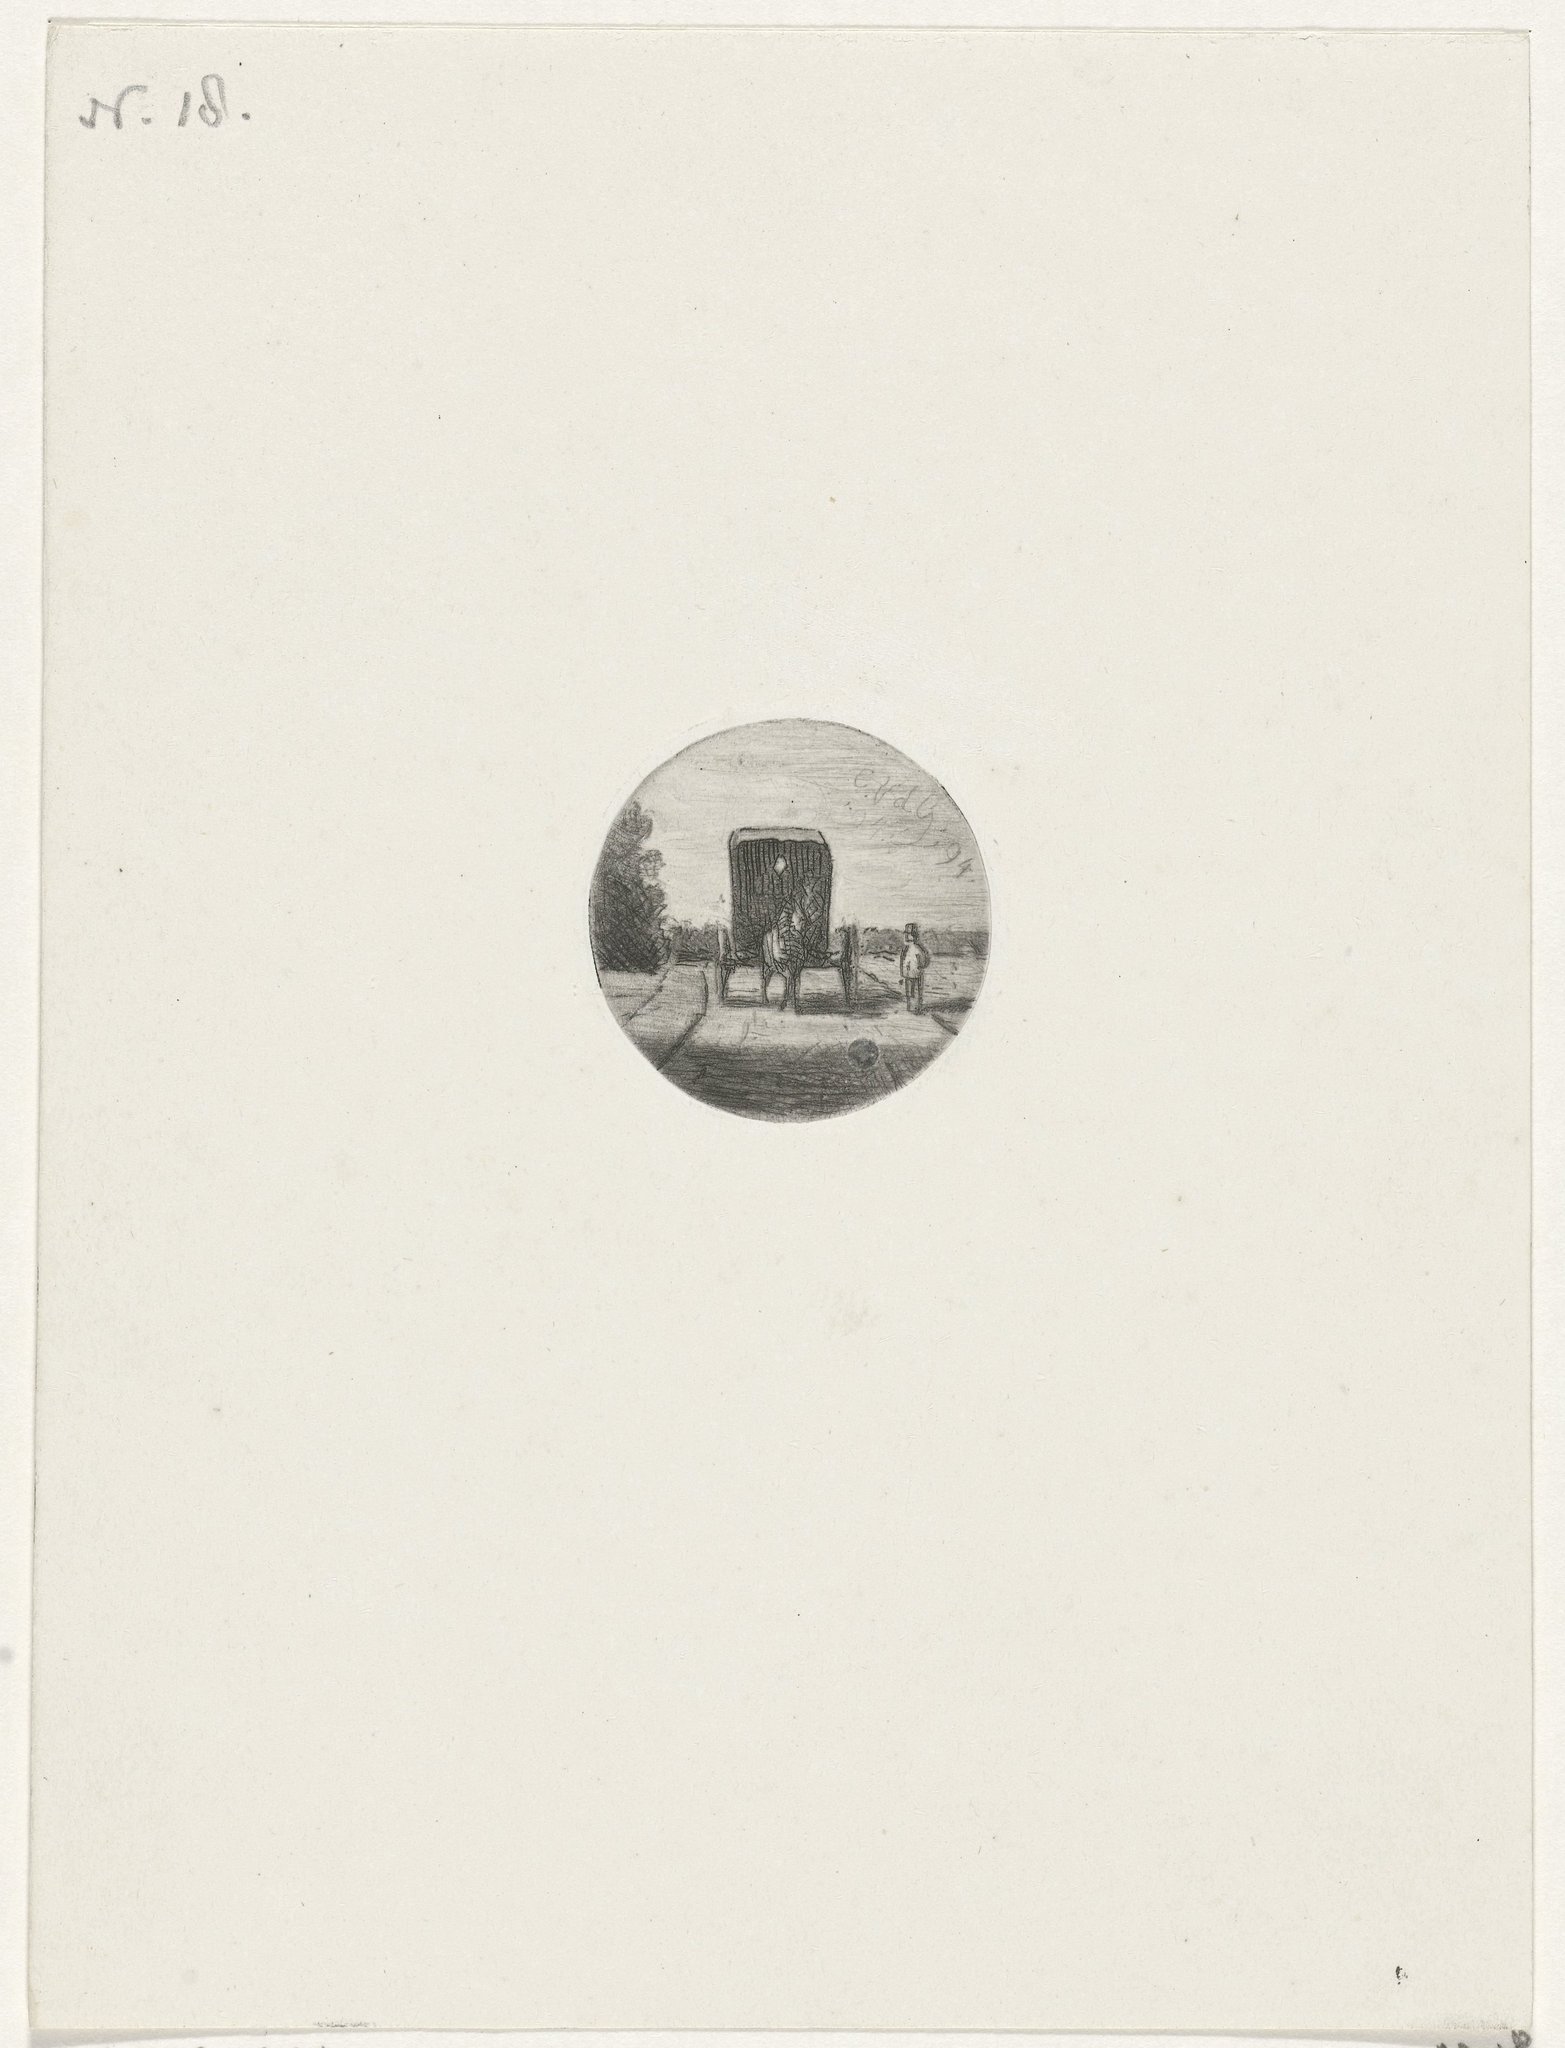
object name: print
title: Koets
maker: cornelis van der griendt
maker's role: draughtsman, painter, print maker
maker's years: 1827-1918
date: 1894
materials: paper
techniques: drypoint, etching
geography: netherlands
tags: two-wheeled, animal-drawn vehicle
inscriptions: collector's mark: Lugt 2228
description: Een dokterskoets van voren gezien op een weg in een landschap. Rechts loopt een figuur aan de rand van de weg.